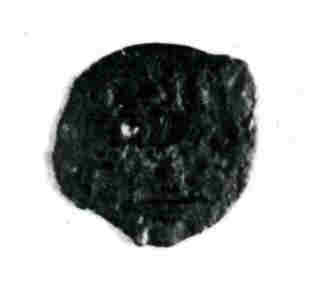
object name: coin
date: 786-808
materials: copper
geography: iran